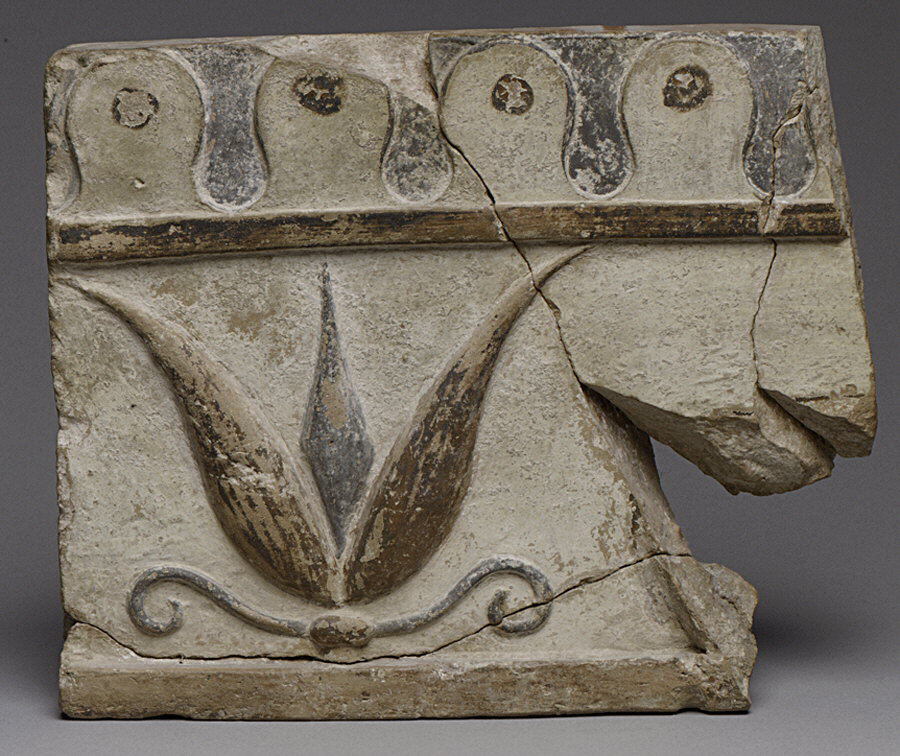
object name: tile fragment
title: Terracotta architectural tile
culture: lydian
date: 600-501 BCE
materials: terracotta